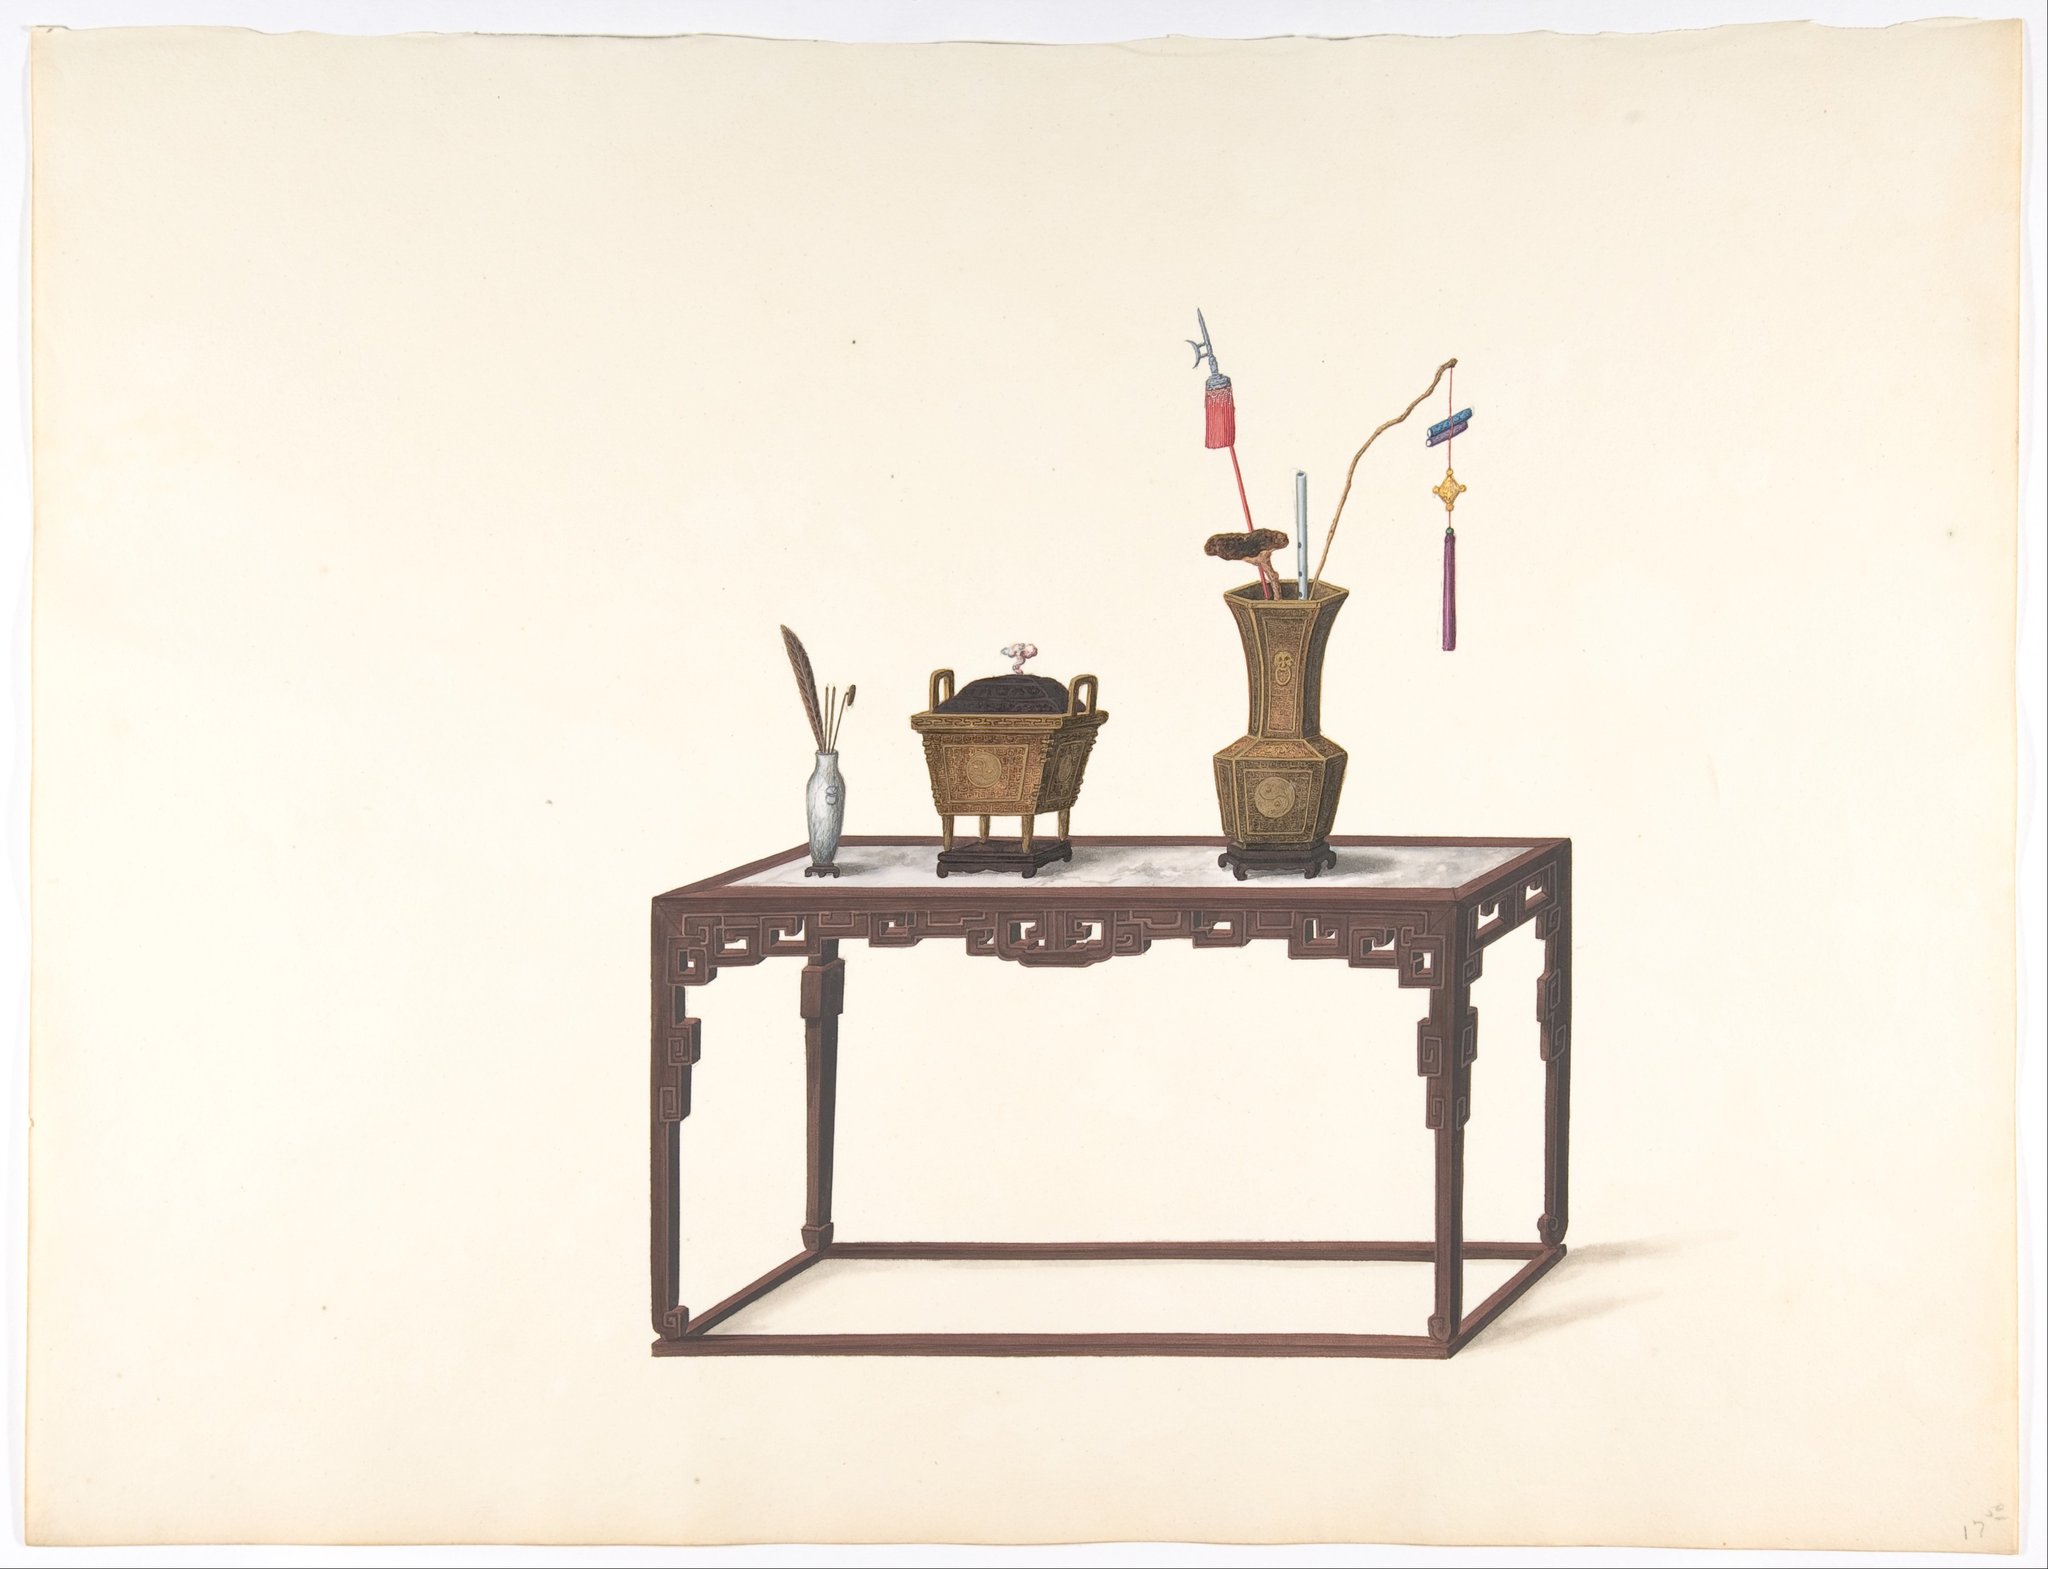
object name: drawing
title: Table with Ornamental Objects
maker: anonymous, chinese, 19th century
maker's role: artist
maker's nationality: chinese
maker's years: 1800-1900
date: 1801-1900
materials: gouache, ink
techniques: pen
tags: tables,vases